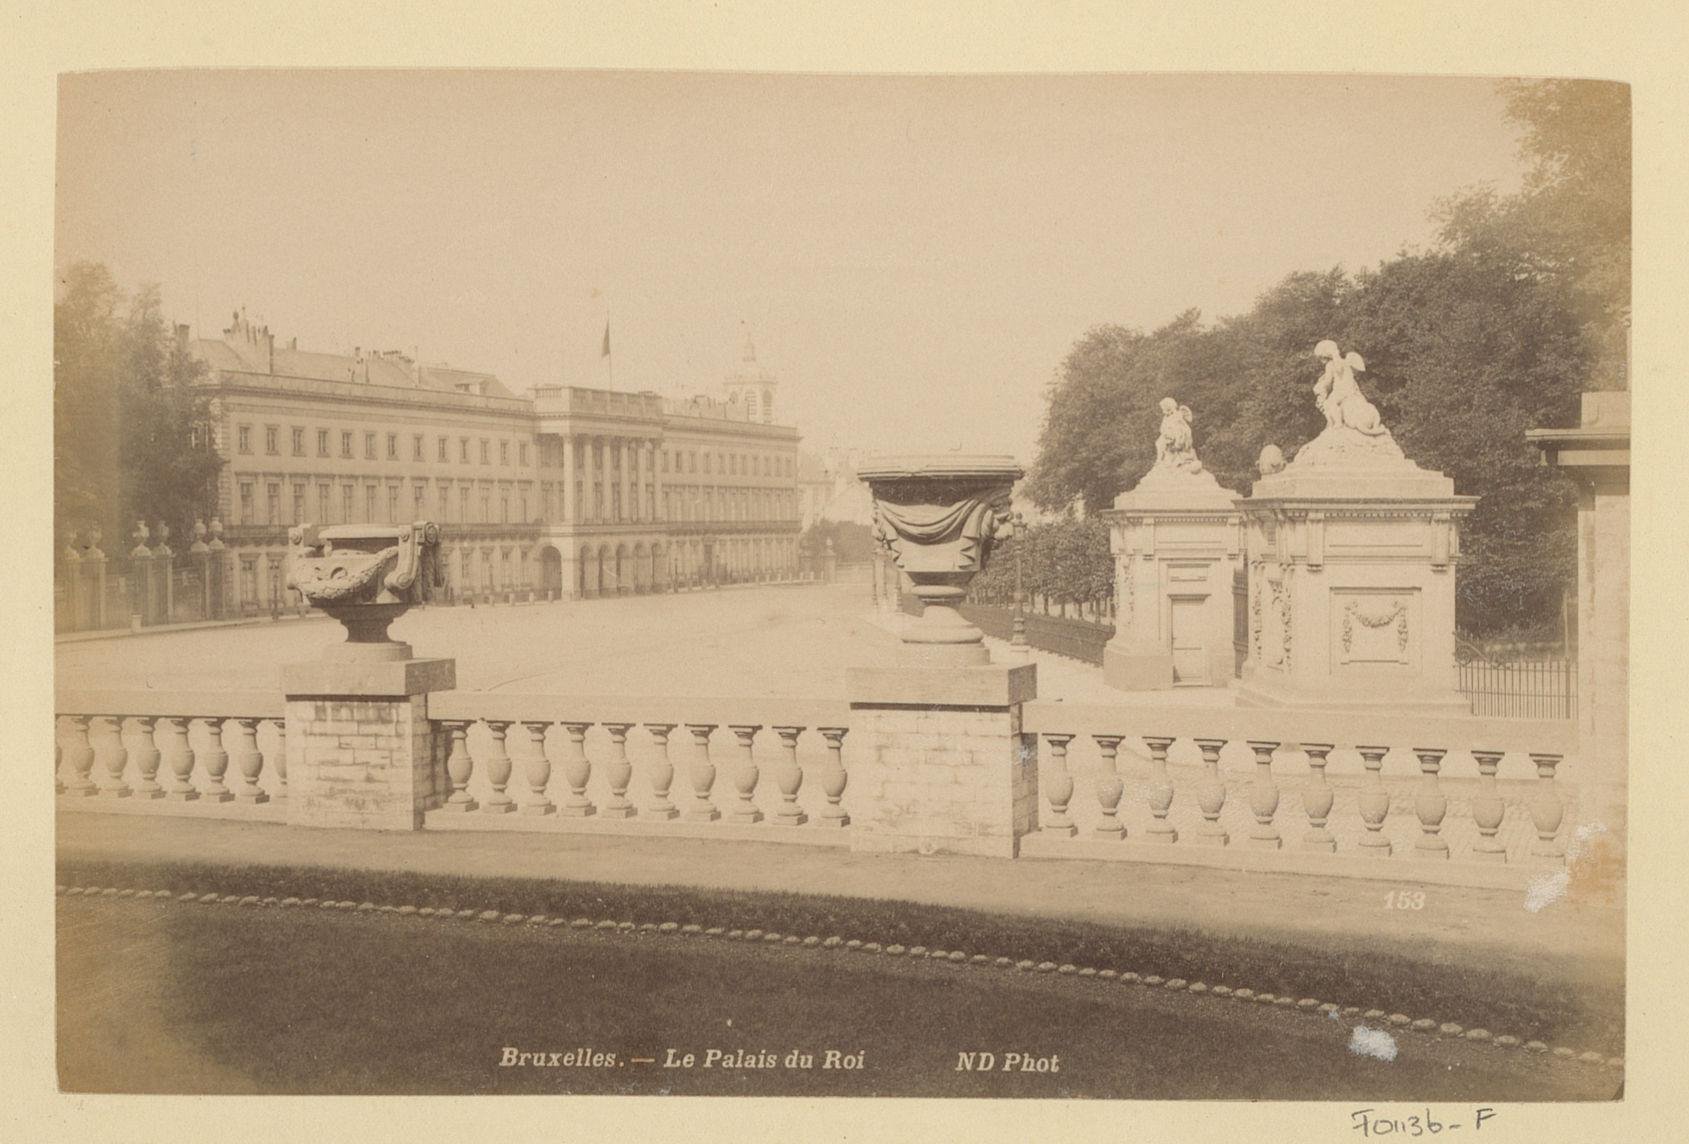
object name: photograph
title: Exterieur van het Koninklijk Paleis in Brussel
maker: étienne neurdein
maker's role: publisher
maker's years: 1832-1918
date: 1870-1892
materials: photographic support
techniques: albumen print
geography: brussels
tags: palace, façade (of house or building)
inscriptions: number: ‘153’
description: Onderdeel van Fotoalbum met opnames van bezienswaardigheden in België, Duitsland en Noorwegen.